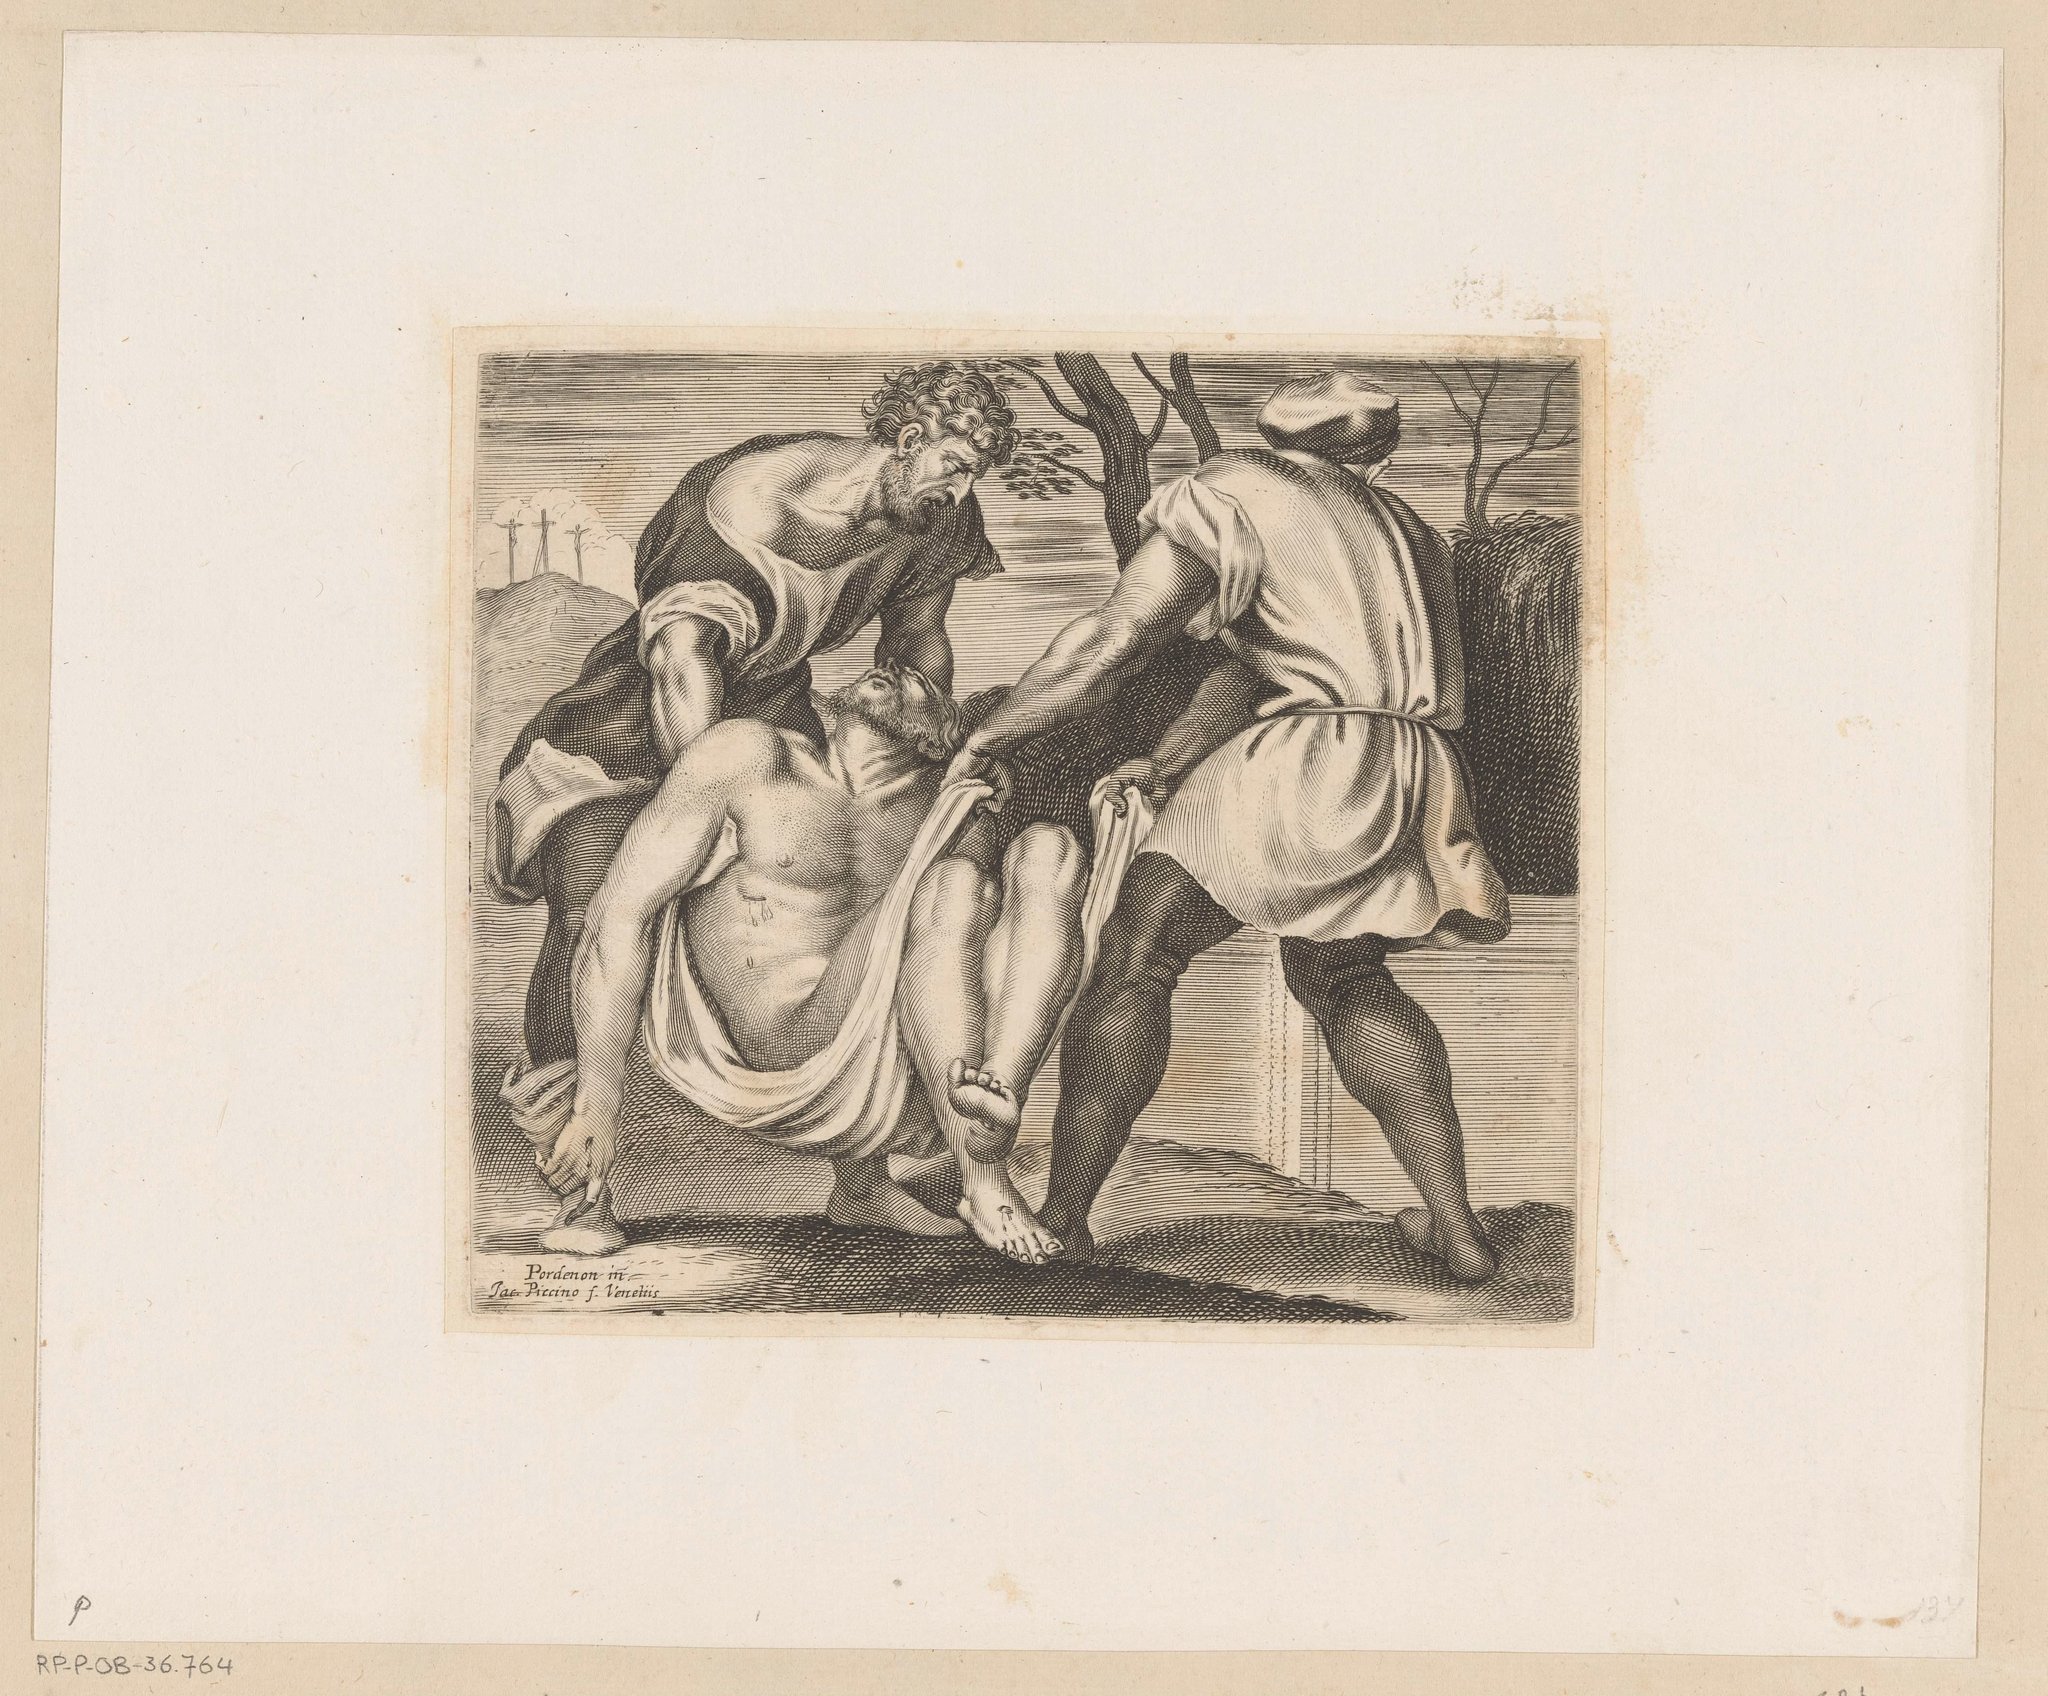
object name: print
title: Graflegging van Christus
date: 1627-1669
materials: paper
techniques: engraving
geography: venice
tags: christ's entombment (possibly by angels)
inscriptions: collector's mark: Lugt 240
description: Deze prent maakt onderdeel uit van een serie van vijf prenten naar verloren gegane fresco's door Pordenone in het klooster van de Santo Stefano te Venetië. De prent is buiten de plaatrand afgesneden en op een blad geplakt voorzien van een imitatieplaatrand.